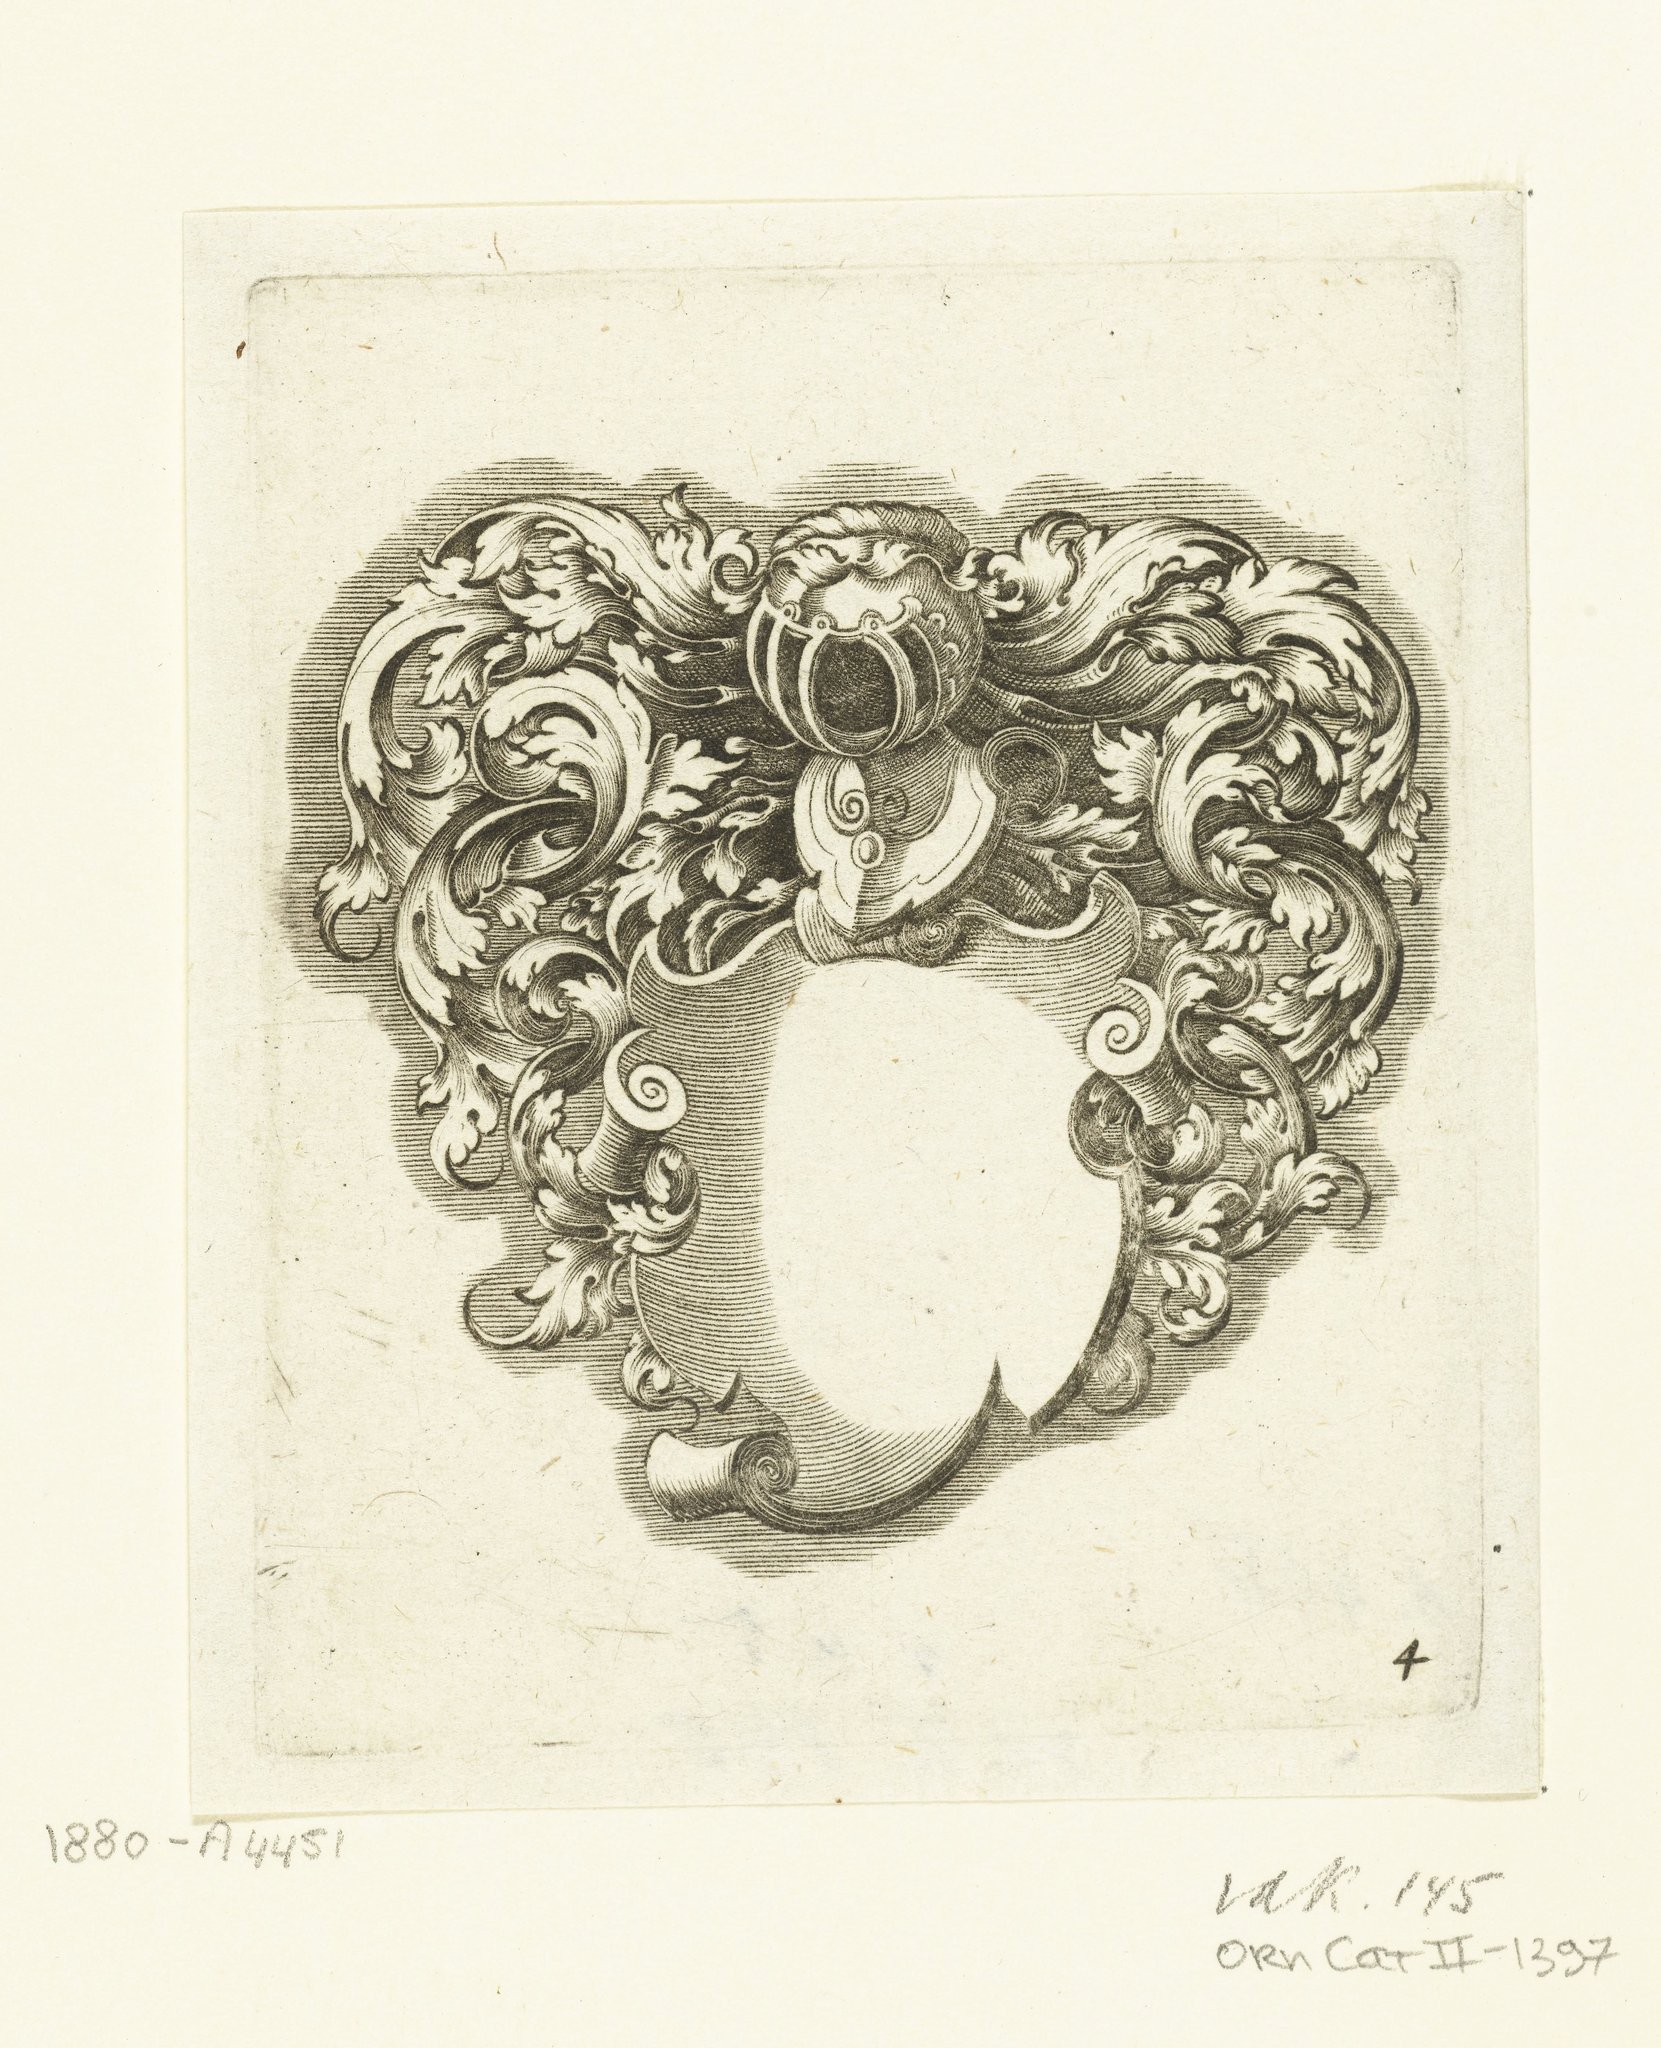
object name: print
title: Wapenschild van Jacomo Pauw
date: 1627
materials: paper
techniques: engraving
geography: amsterdam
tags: armorial bearing, heraldry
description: Verkleinde tegenzijdige kopie van het wapenschild, zonder de pauw op de helm, zonder banderol en met een leeg schild.